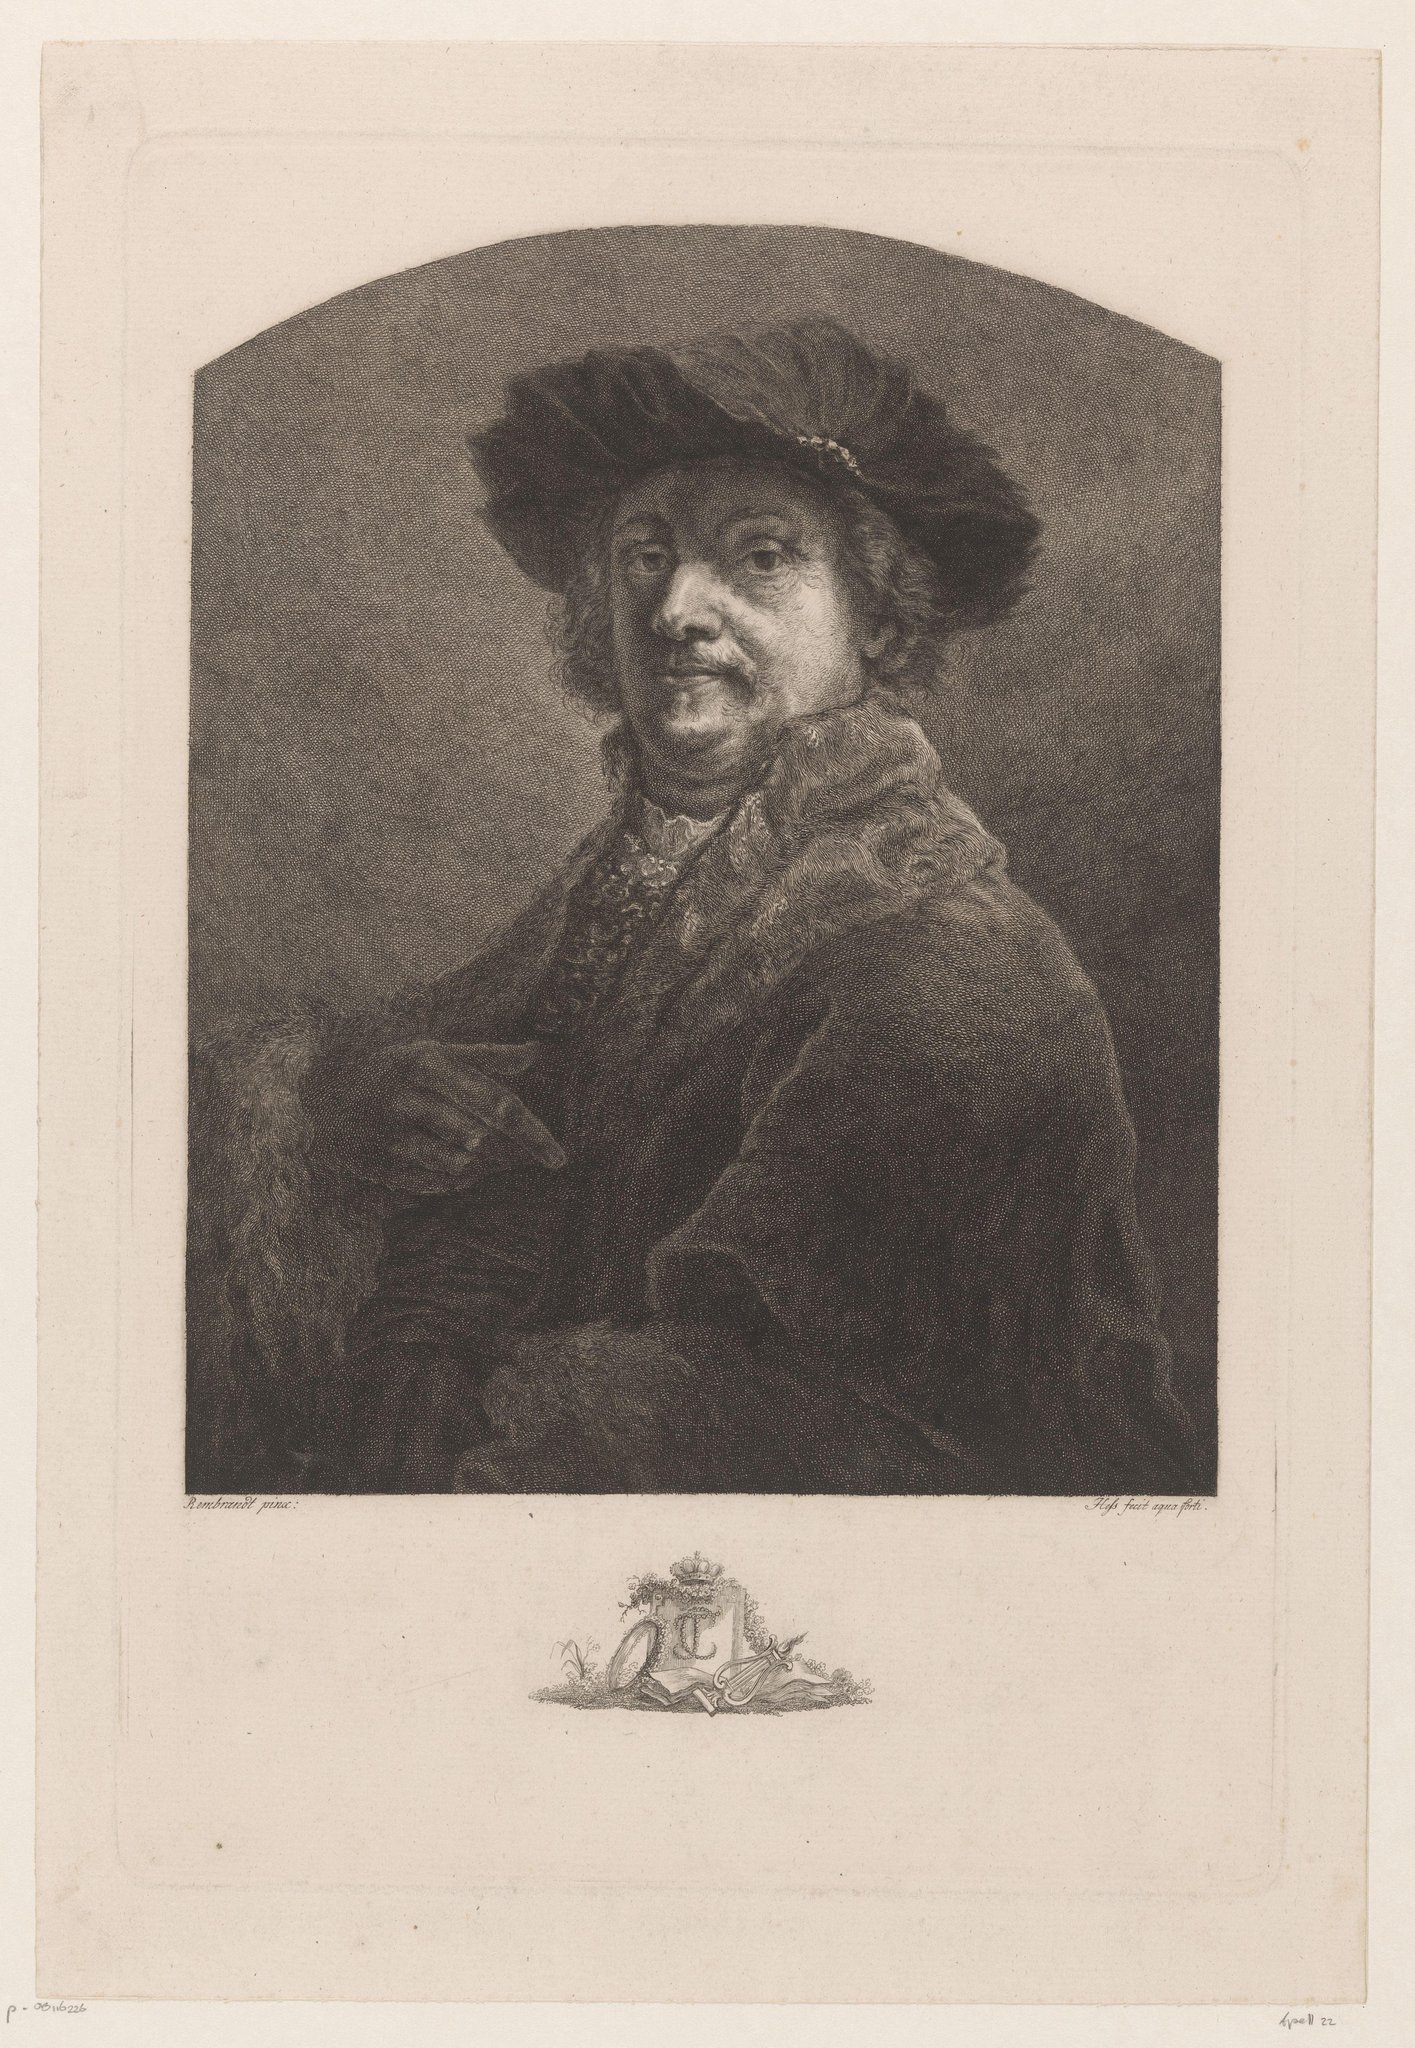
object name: print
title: Portret van Rembrandt van Rijn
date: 1765-1828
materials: paper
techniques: etching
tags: leiden, amsterdam, painter, print maker, draughtsman, rembrandt van rijn, the liberal arts, 'artes liberales', historical persons, portrait, self-portrait of painter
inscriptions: collector's mark: Lugt 2228